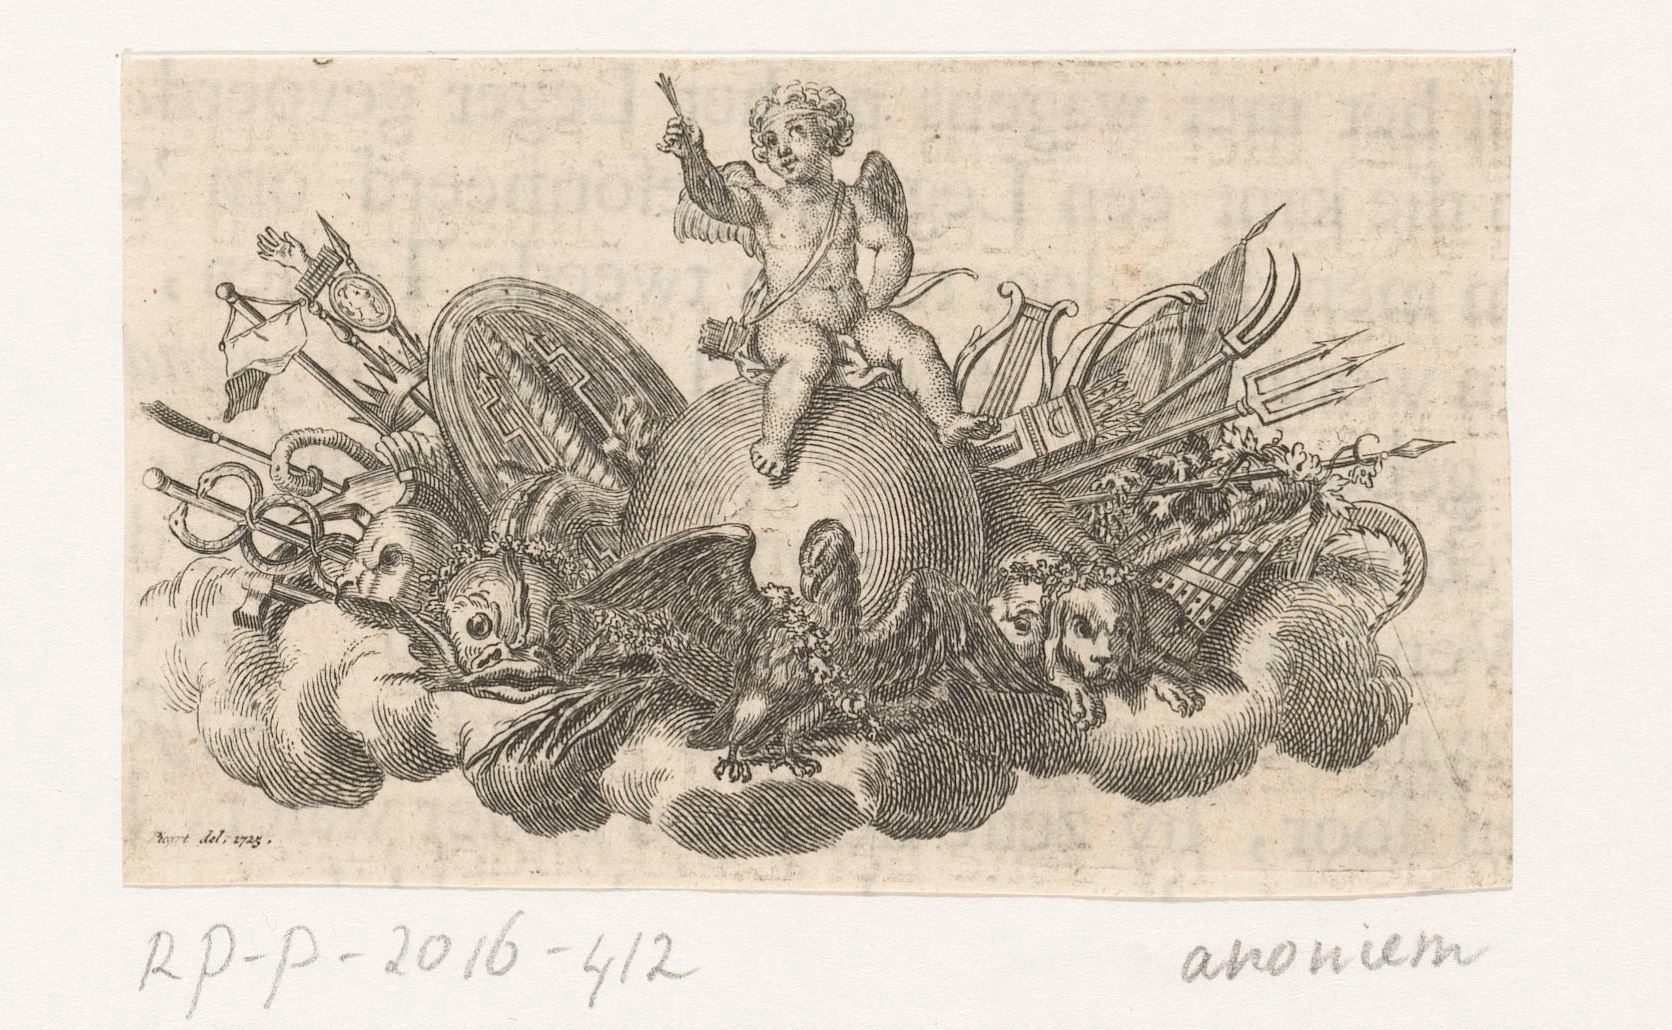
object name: book illustration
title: Triomferende Amor zittend op de wereld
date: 1725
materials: paper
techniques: engraving, etching, letterpress printing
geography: netherlands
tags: 'omnia vincit amor', love the conqueror, love triumphant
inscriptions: date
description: Amor zit op de wereldbol en toont in triomf een pijl, ten teken dat liefde alles overwint. Rond de wereldbol verschillende wereldlijke attributen, zoals kronen, lansen, attributen van de verschillende kunsten en de driekoppige hellehond Cerberus.